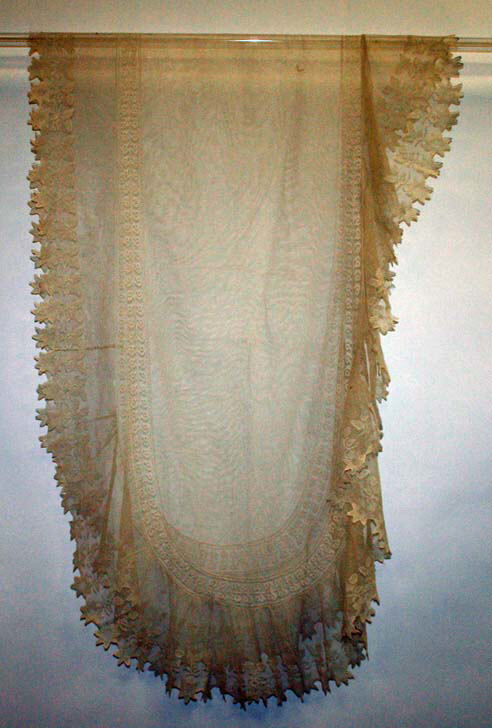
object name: scarf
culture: american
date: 1820-1830